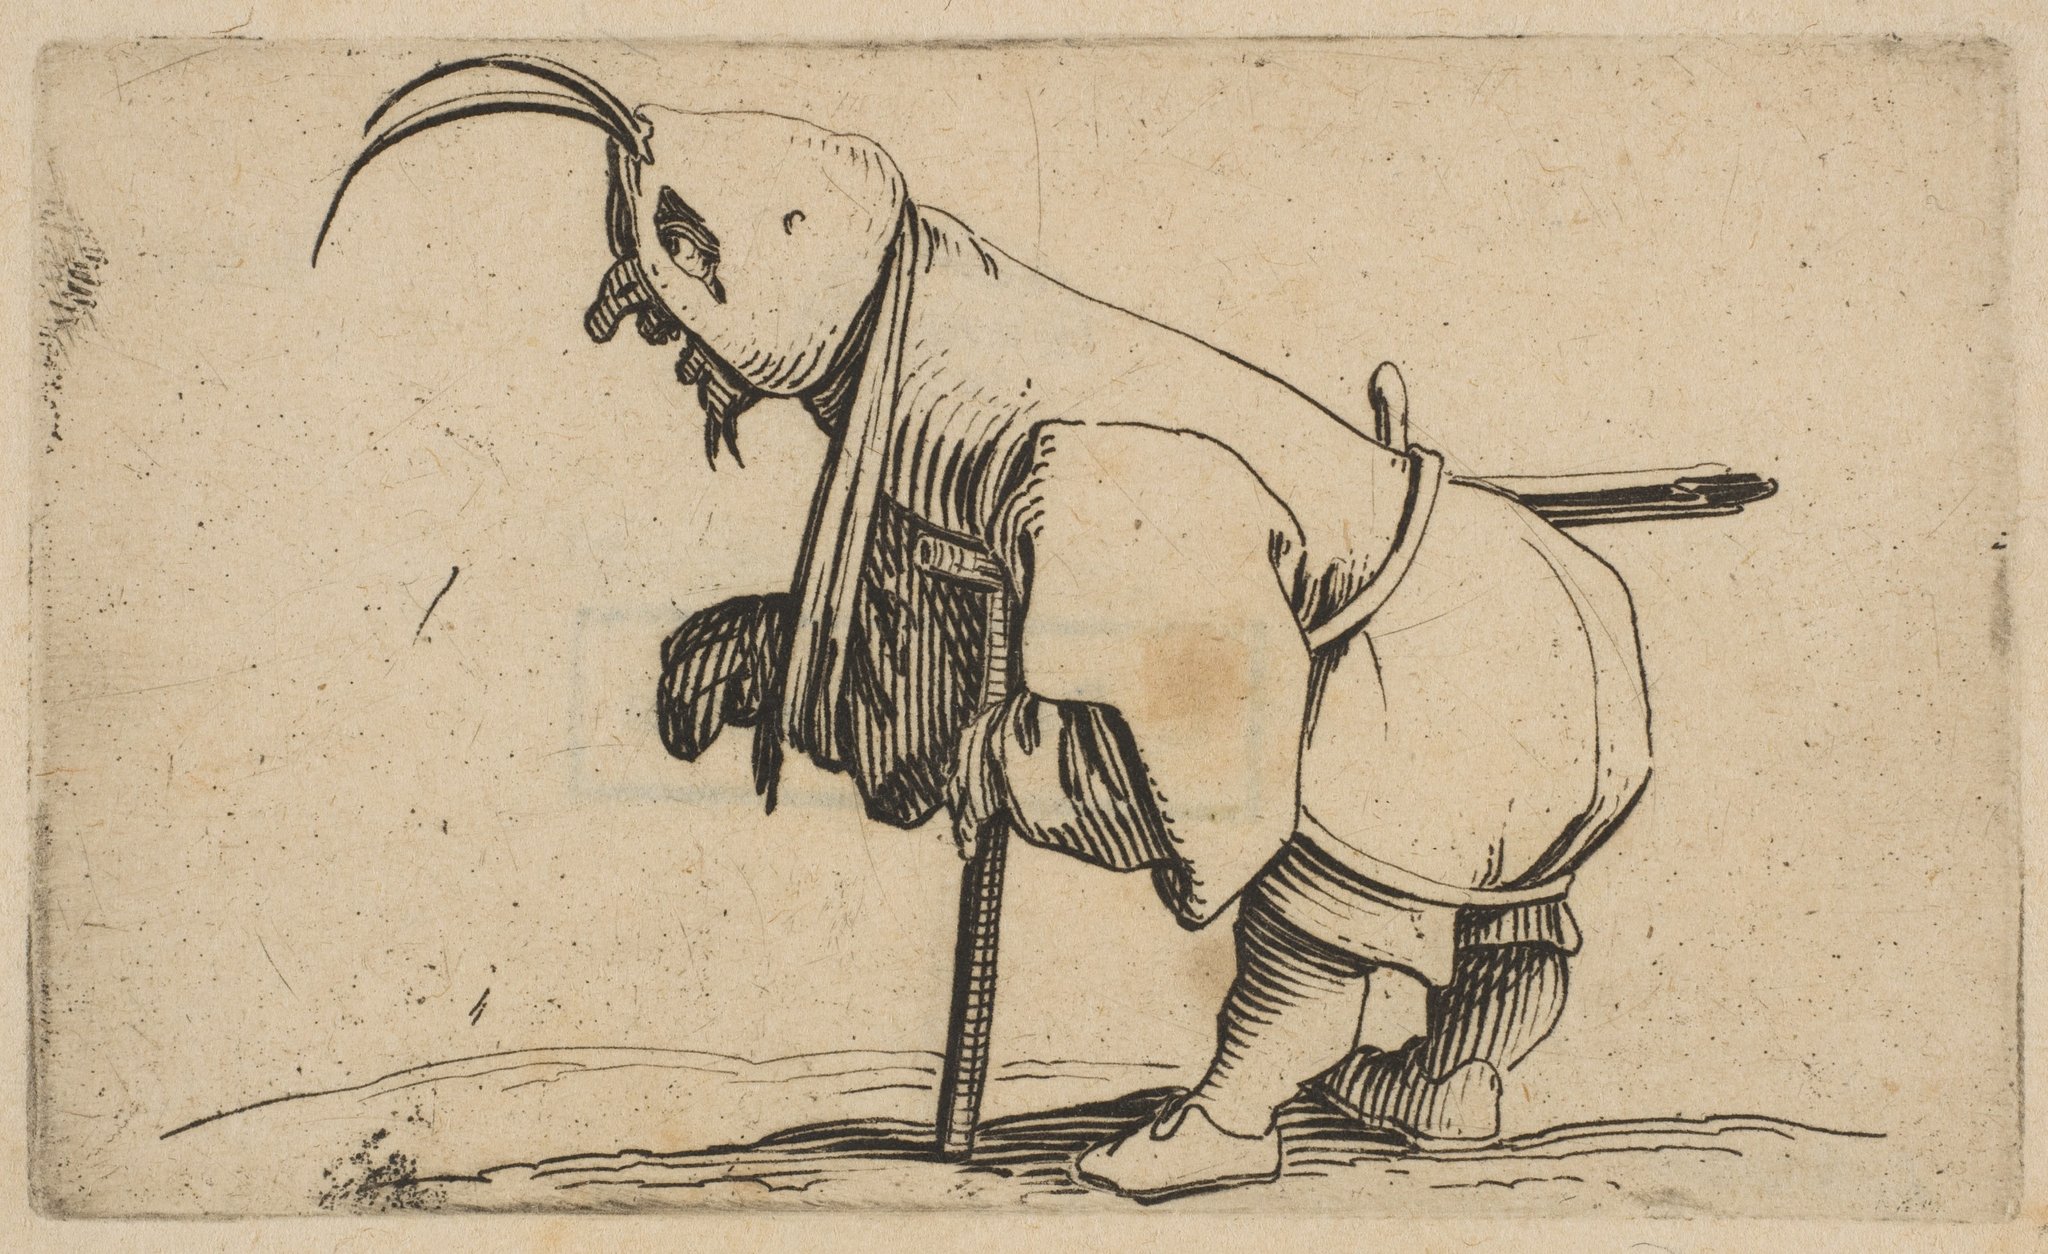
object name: print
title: L'Estropié au Capuchon (The Beggar Wearing a Hood), from "Varie Figure Gobbi, suite appelée aussi Les Bossus, Les Pygmées, Les Nains Grotesques" (Various Hunchbacked Figures, The Hunchbacks, The Pygmes, The Grotesque Dwarfs)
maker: jacques callot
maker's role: artist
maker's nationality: french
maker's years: 1592-1635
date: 1616-1622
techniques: engraving, etching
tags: men